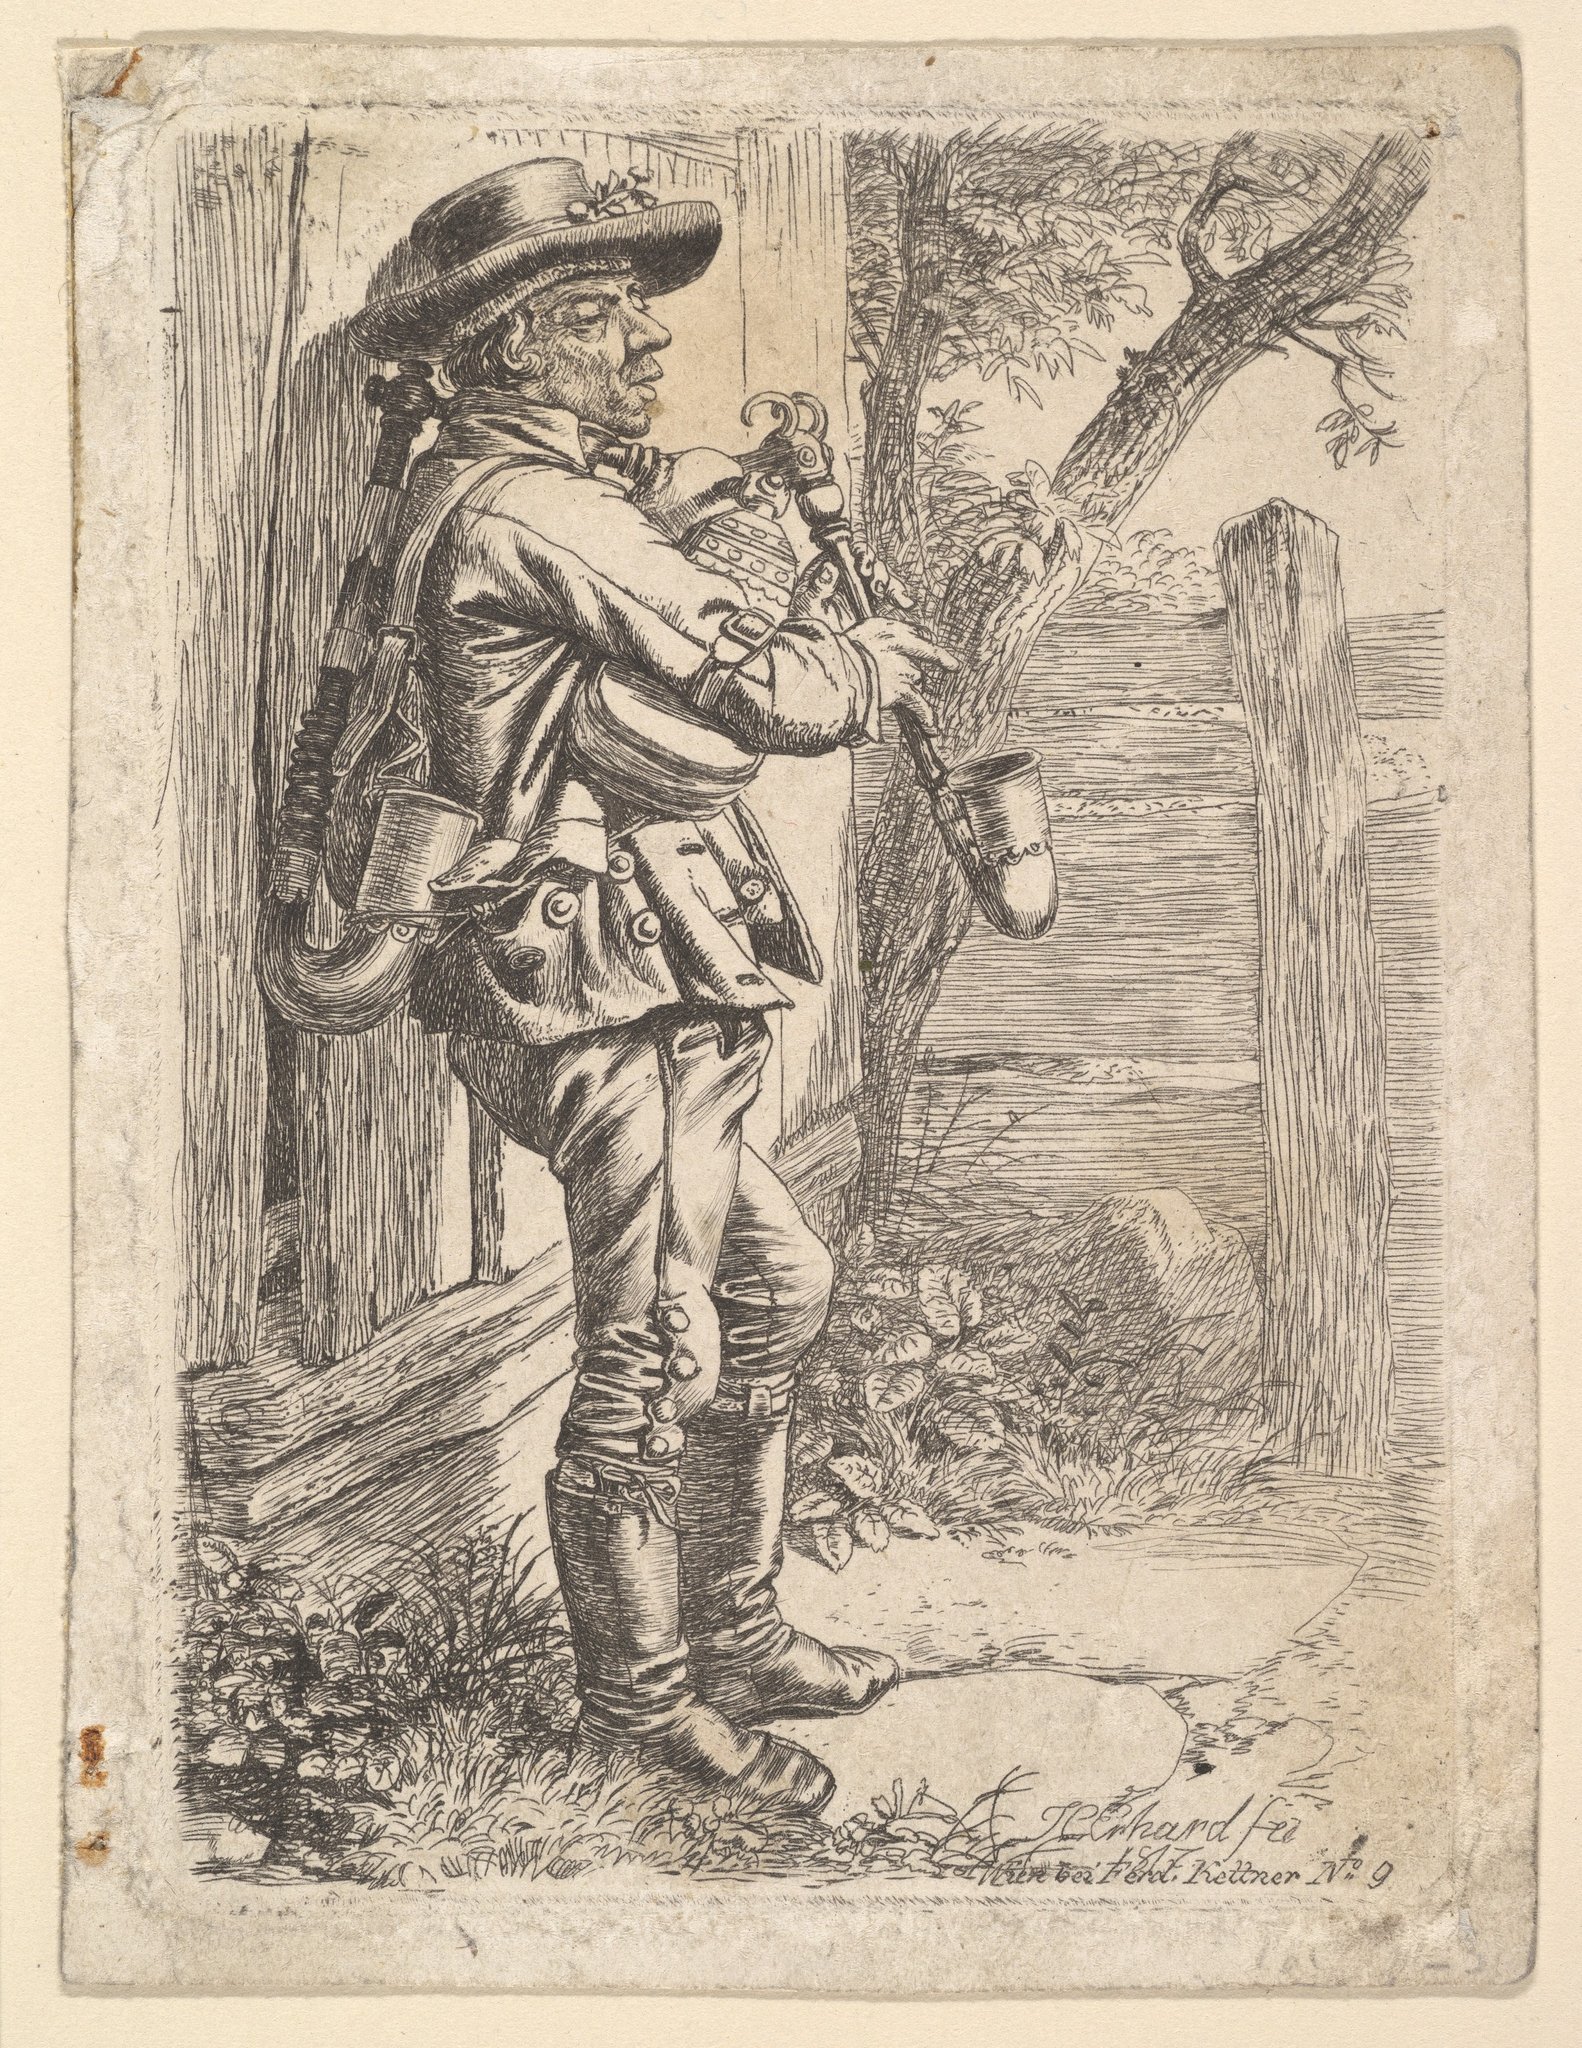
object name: print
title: The Bagpiper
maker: johann christoph erhard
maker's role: artist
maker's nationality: german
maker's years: 1795-1822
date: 1817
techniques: etching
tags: men,bagpipes,musicians